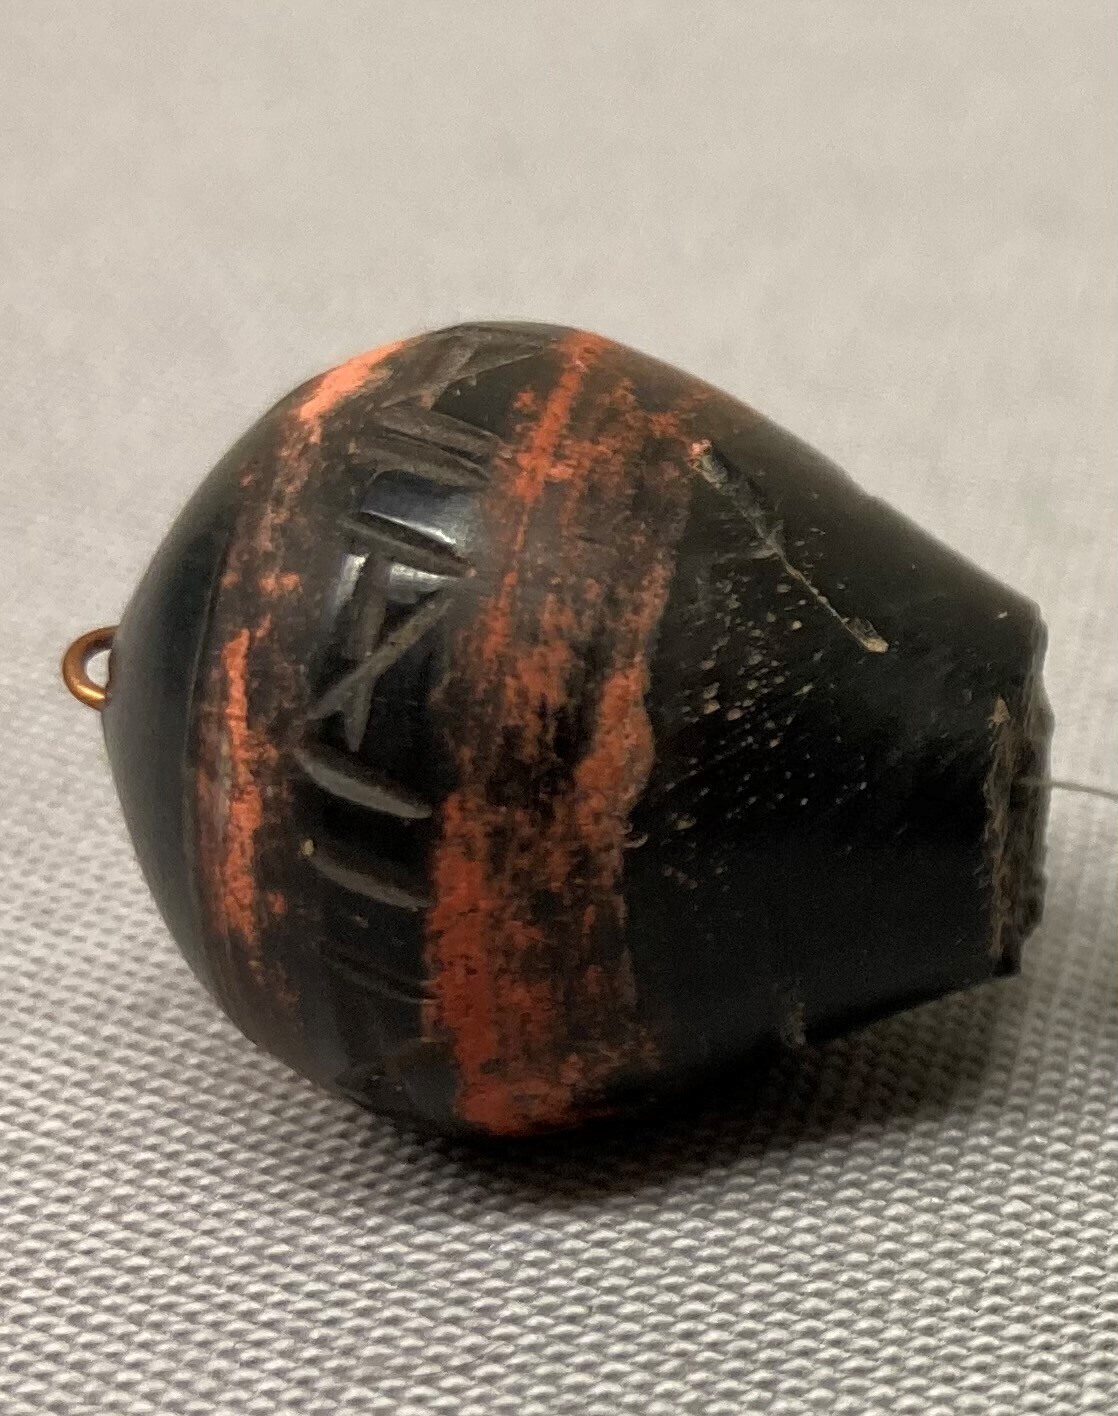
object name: bead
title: Stone Beads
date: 701-1200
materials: stone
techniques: incising, painting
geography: iran